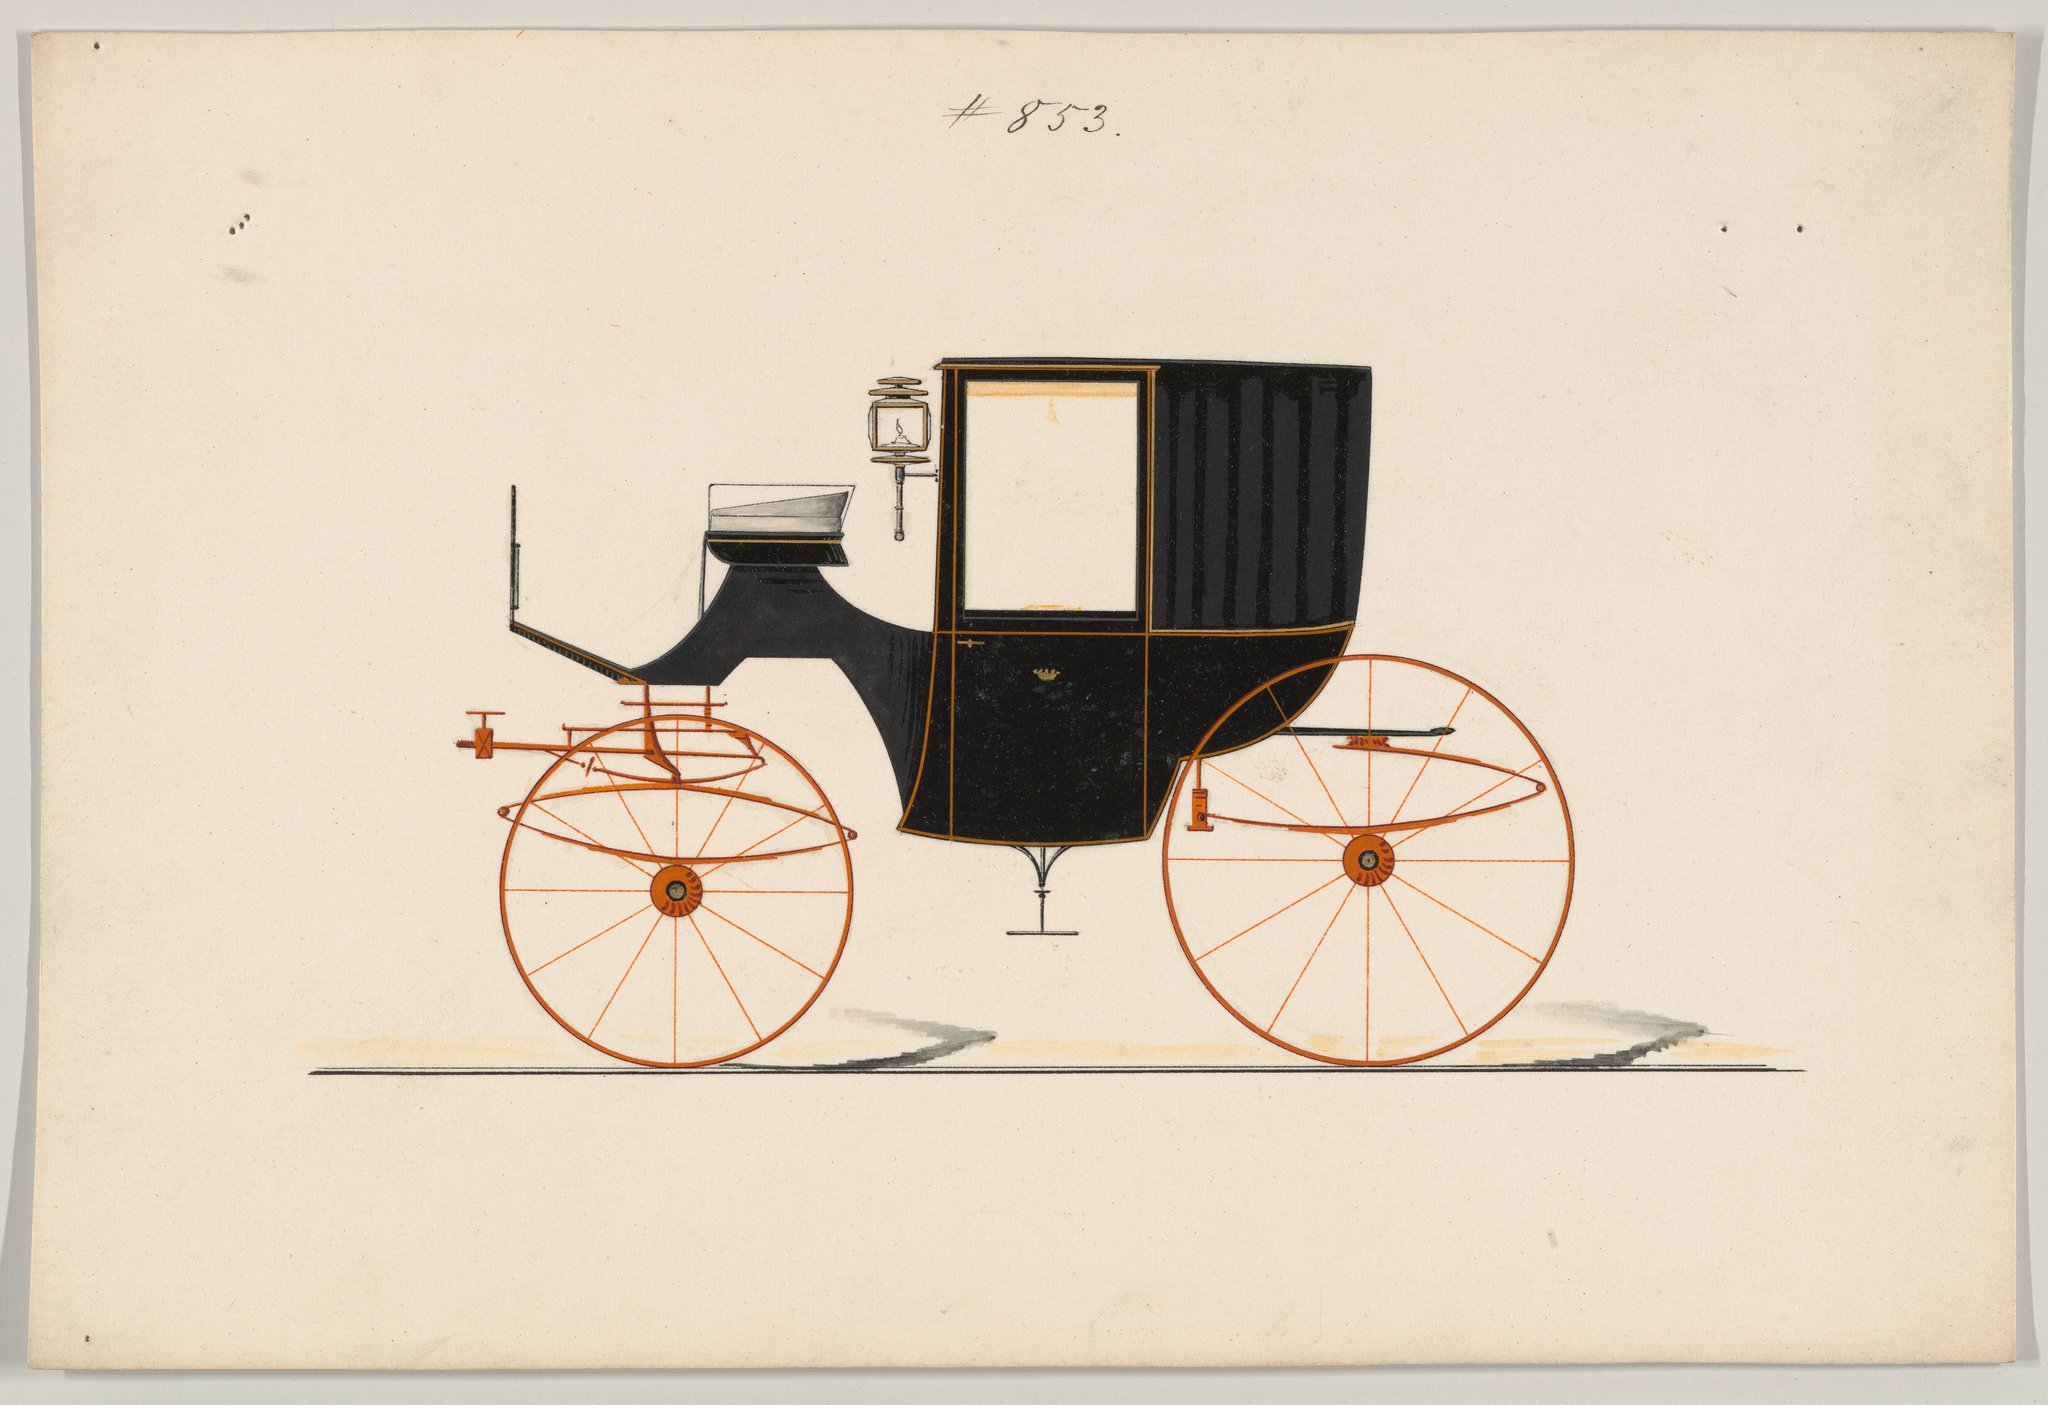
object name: drawing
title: Coupe # 853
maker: brewster & co.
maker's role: manufacturer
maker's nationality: american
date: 1865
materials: gouache, gum arabic, ink, watercolor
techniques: pen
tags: carriages